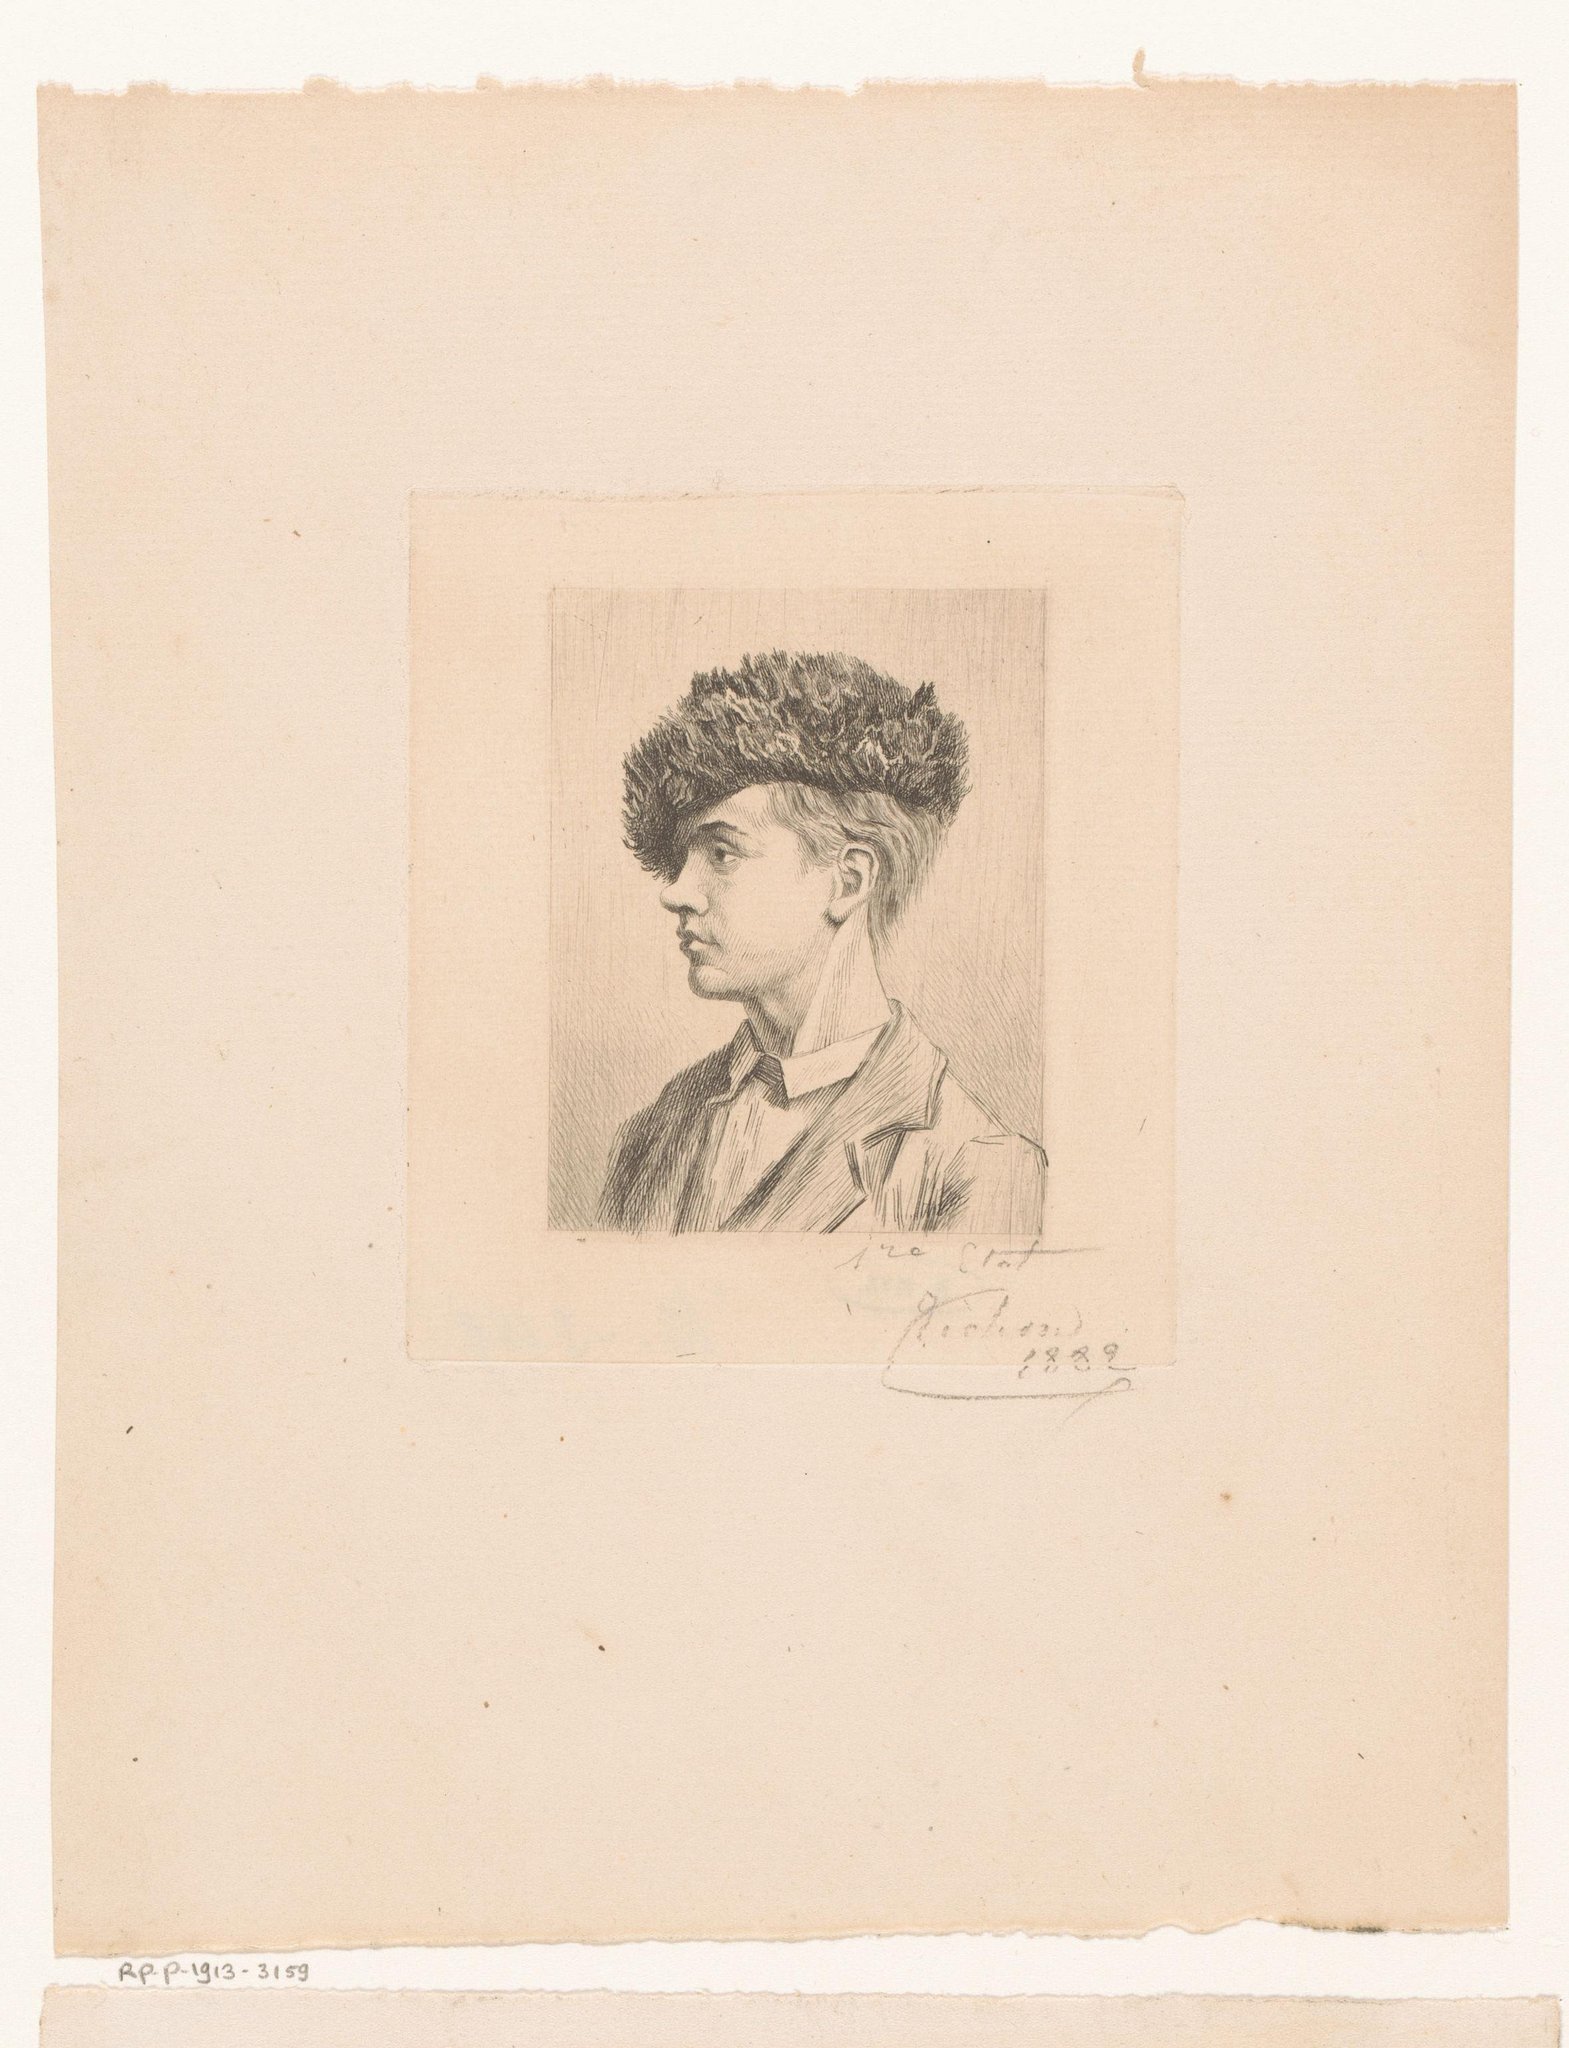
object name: print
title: Portret van een onbekende jongeman met muts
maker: charles tichon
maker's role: draughtsman, painter, print maker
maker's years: 1865-1924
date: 1882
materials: paper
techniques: etching, intaglio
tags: head-gear: cap (+ men's clothes), historical persons, youth, adolescent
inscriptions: inscription: ‘1re Etat; 1882’, collector's mark: Lugt 2228